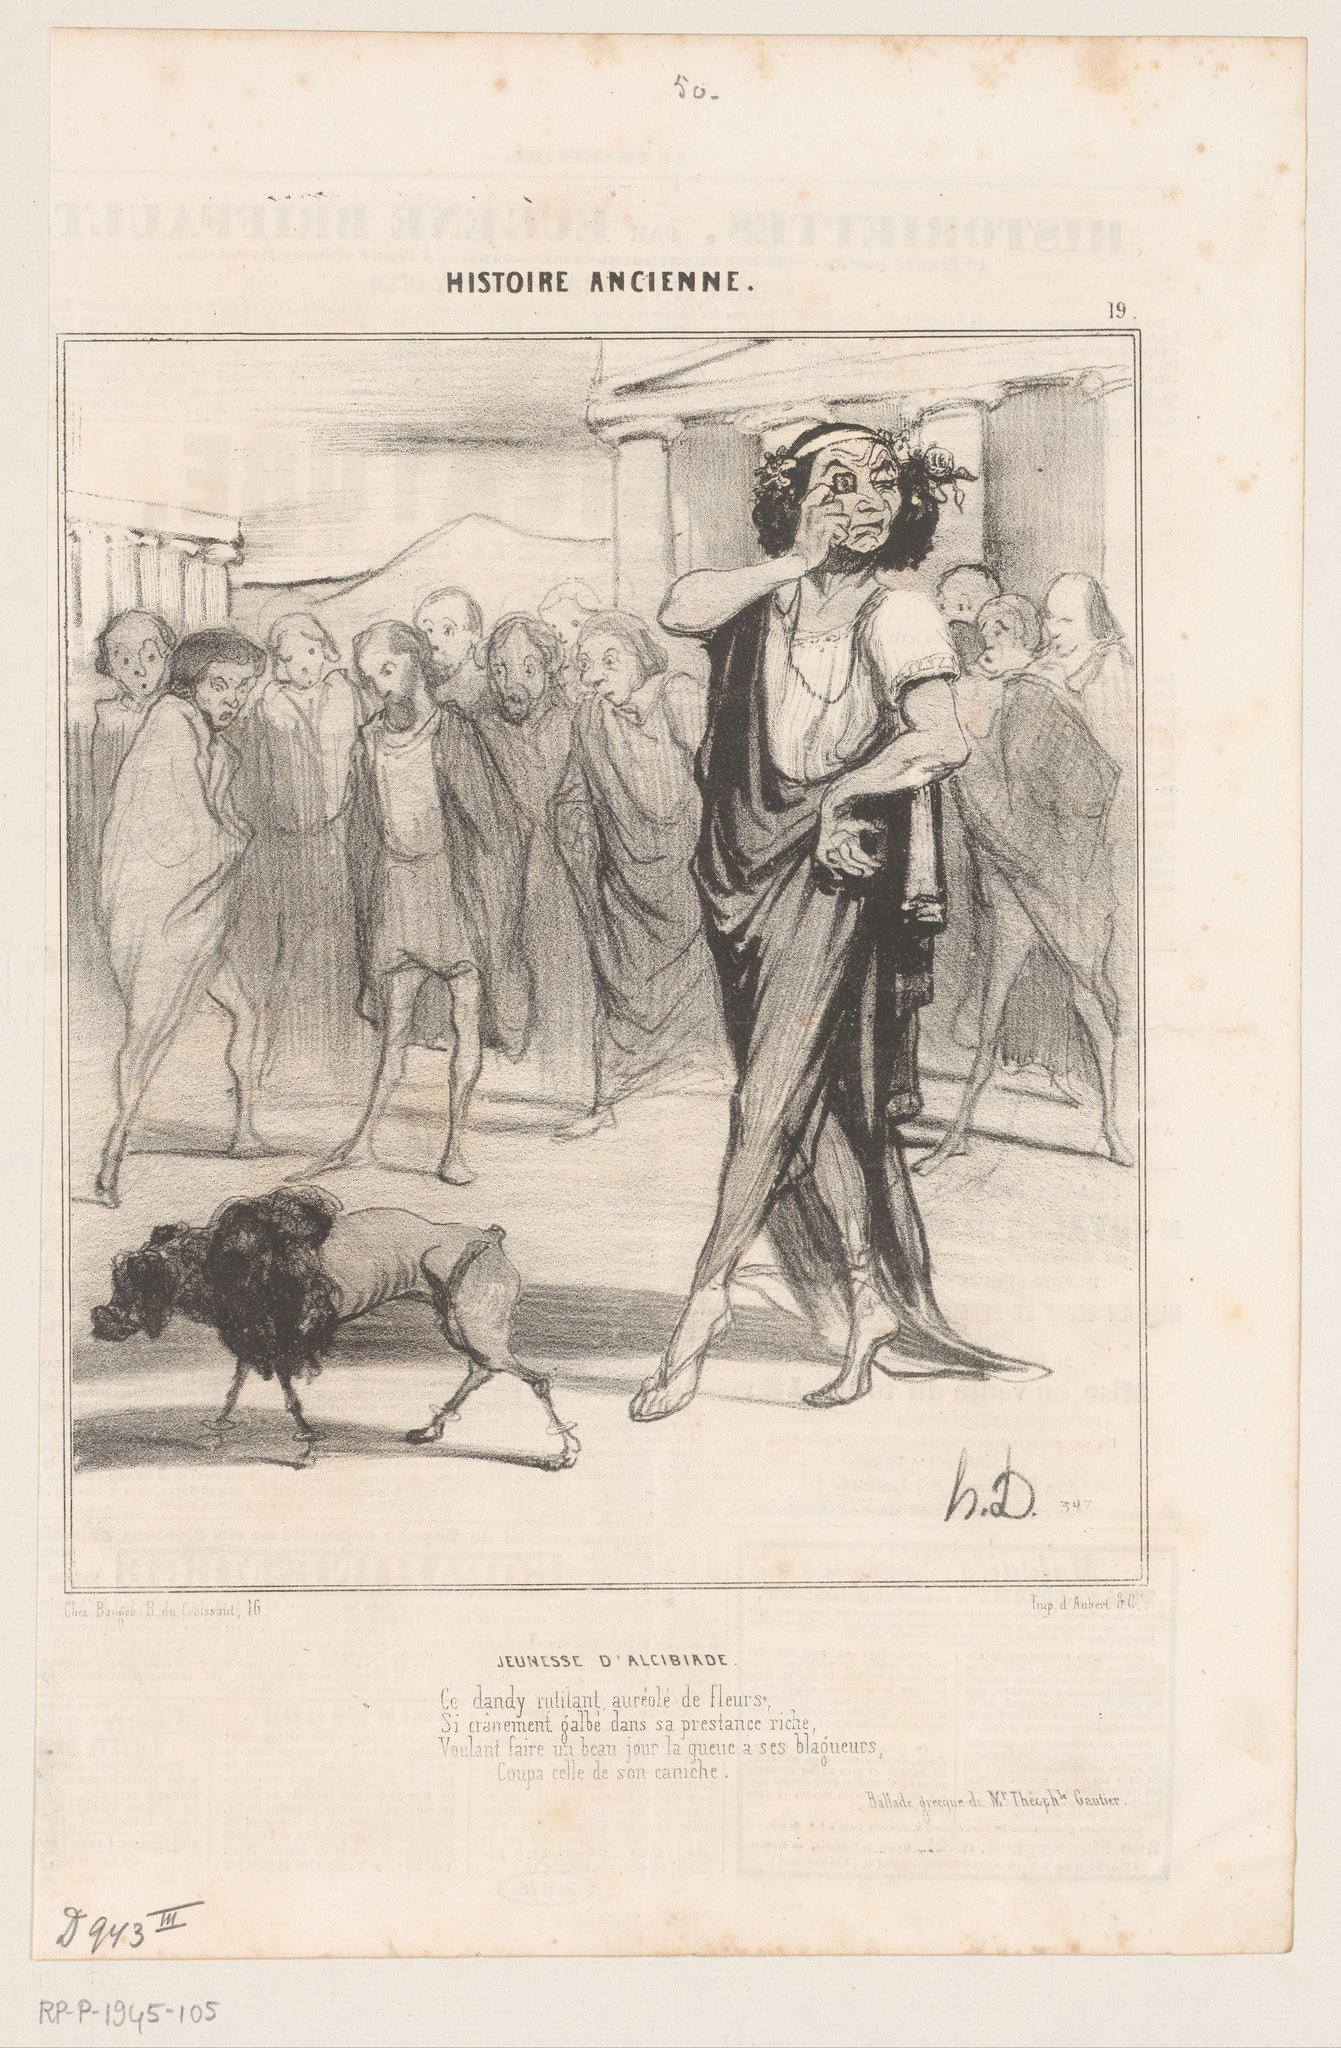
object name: cartoon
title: Jeunesse d'Alcibiade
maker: honoré daumier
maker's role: draughtsman, painter, print maker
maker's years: 1808-1879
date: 1842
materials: paper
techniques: lithograph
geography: paris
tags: alcibiades has the tail of his dog cut off to avert the attention of the athenians from his other doings (+ caricature), historical persons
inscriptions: collector's mark: Lugt 2228a, number: ‘50’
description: Prent gepubliceerd in: Le Charivari, Aubert: Parijs, 17-07-1842. Le Charivari was een humoristische krant met karikaturen en (politieke) cartoons.